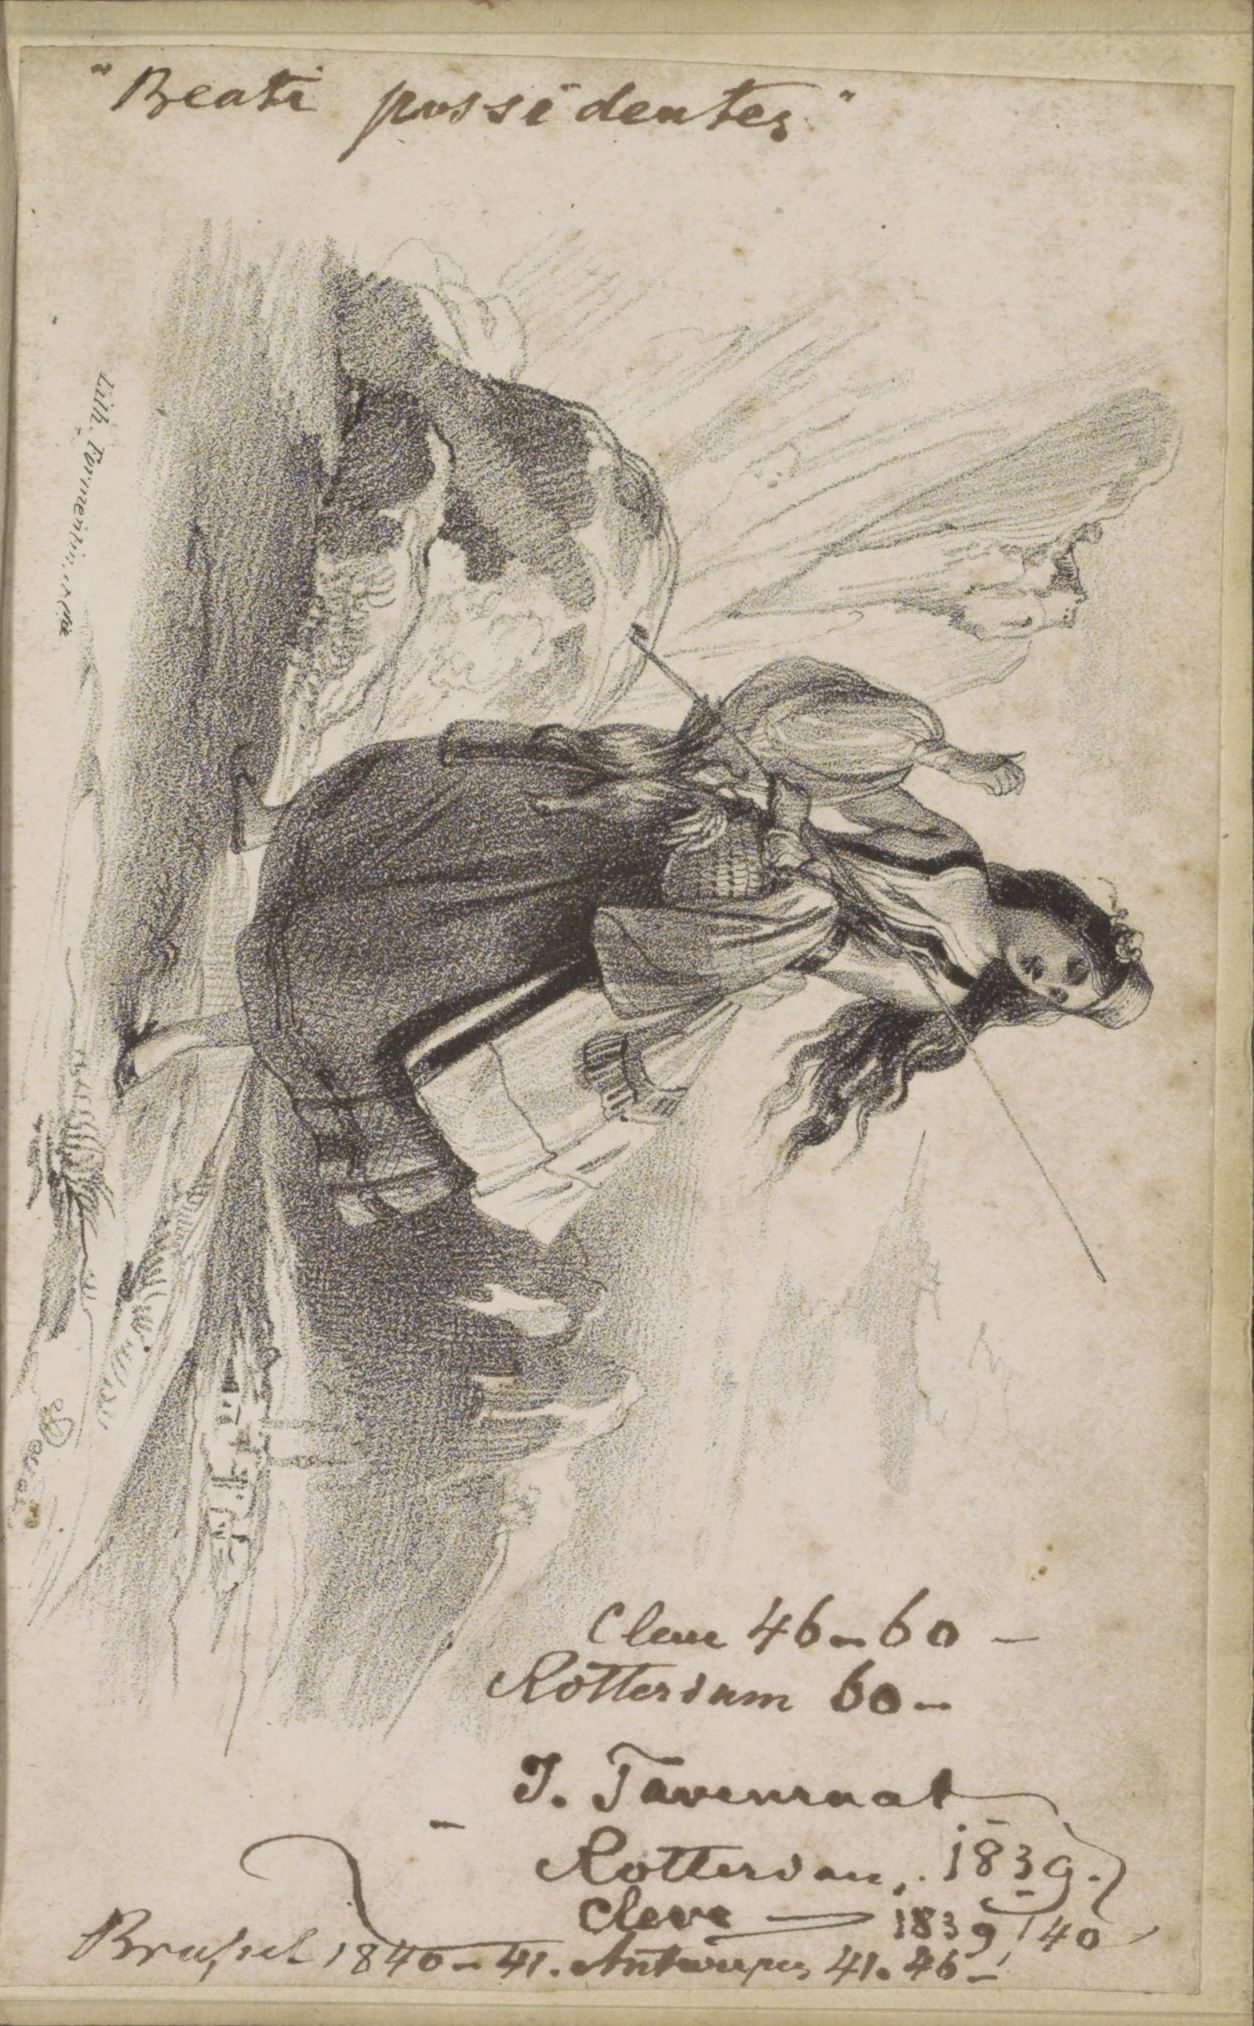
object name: endleaf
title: Annotatie op een ingeplakte prent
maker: johannes tavenraat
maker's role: draughtsman, painter, print maker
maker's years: 1809-1881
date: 1839-1872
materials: ink, paper, pencil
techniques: pen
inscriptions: annotation: ‘"Beate possi dentes"/ Cleve 46-60-/ Rotterdam 60-/ J. Tavenraat/ Rotterdam, 1839./ Cleve 1839/40/ Brussel 1840-41 Antwerpen 41.46-’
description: De prent toont een jonge vrouw in traditioneel kostuum in een berglandschap en is ingeplakt in het schetsboek. Het opschrift op de prent luidt: Lith. Fromentin et Cie/ Deveria. Achterste schutblad uit een schetsboek met 73 bladen.